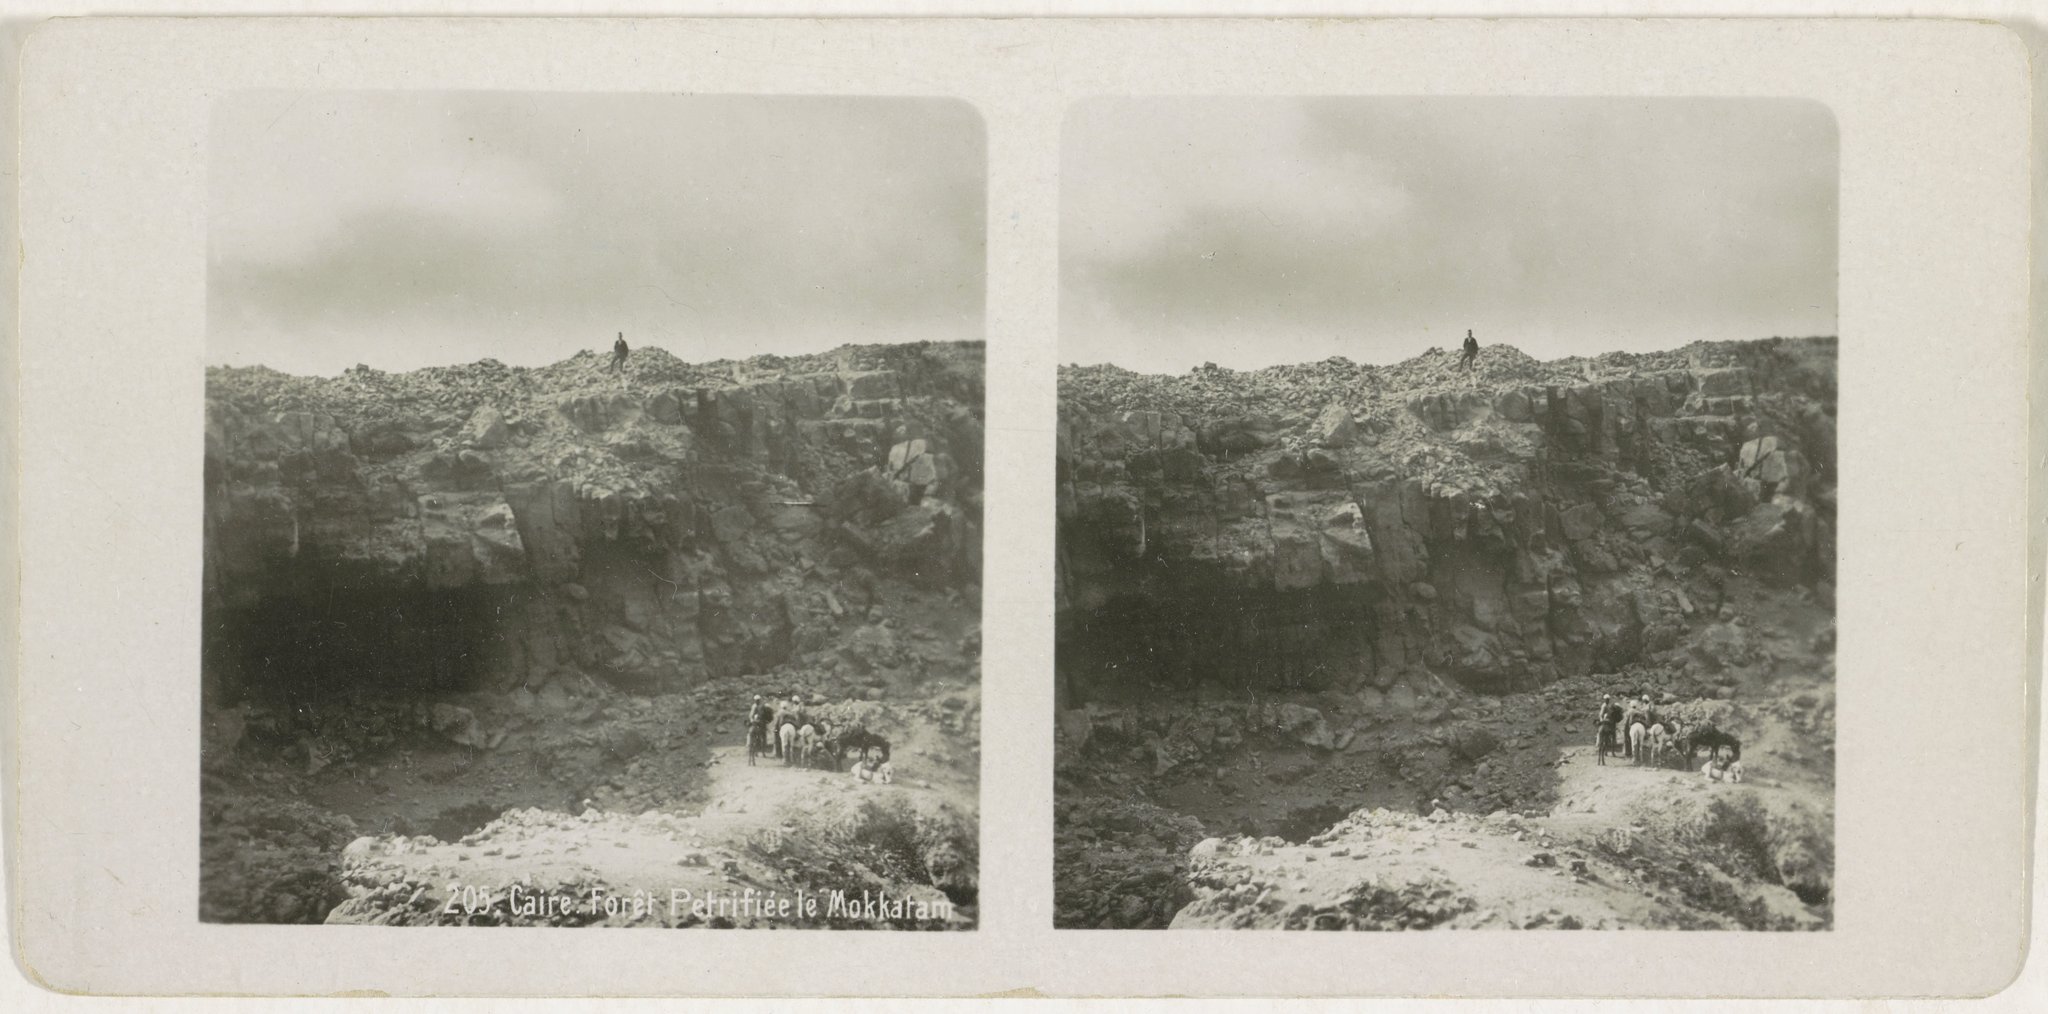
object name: stereograph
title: Collection wereld-tourist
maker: richard sochor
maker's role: painter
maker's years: 1867-1925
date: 1903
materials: paper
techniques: gelatin silver print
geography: haarlem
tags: mountains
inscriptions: address: ‘Parklaan 49/ HAARLEM/ (Holland)’, inscription: ‘Déposée.’, number: ‘205.’, monogram, inscription: ‘Deze stereo-foto's worden in den handel gebracht en en gros en/ en détail verkocht door de ......... (...)’